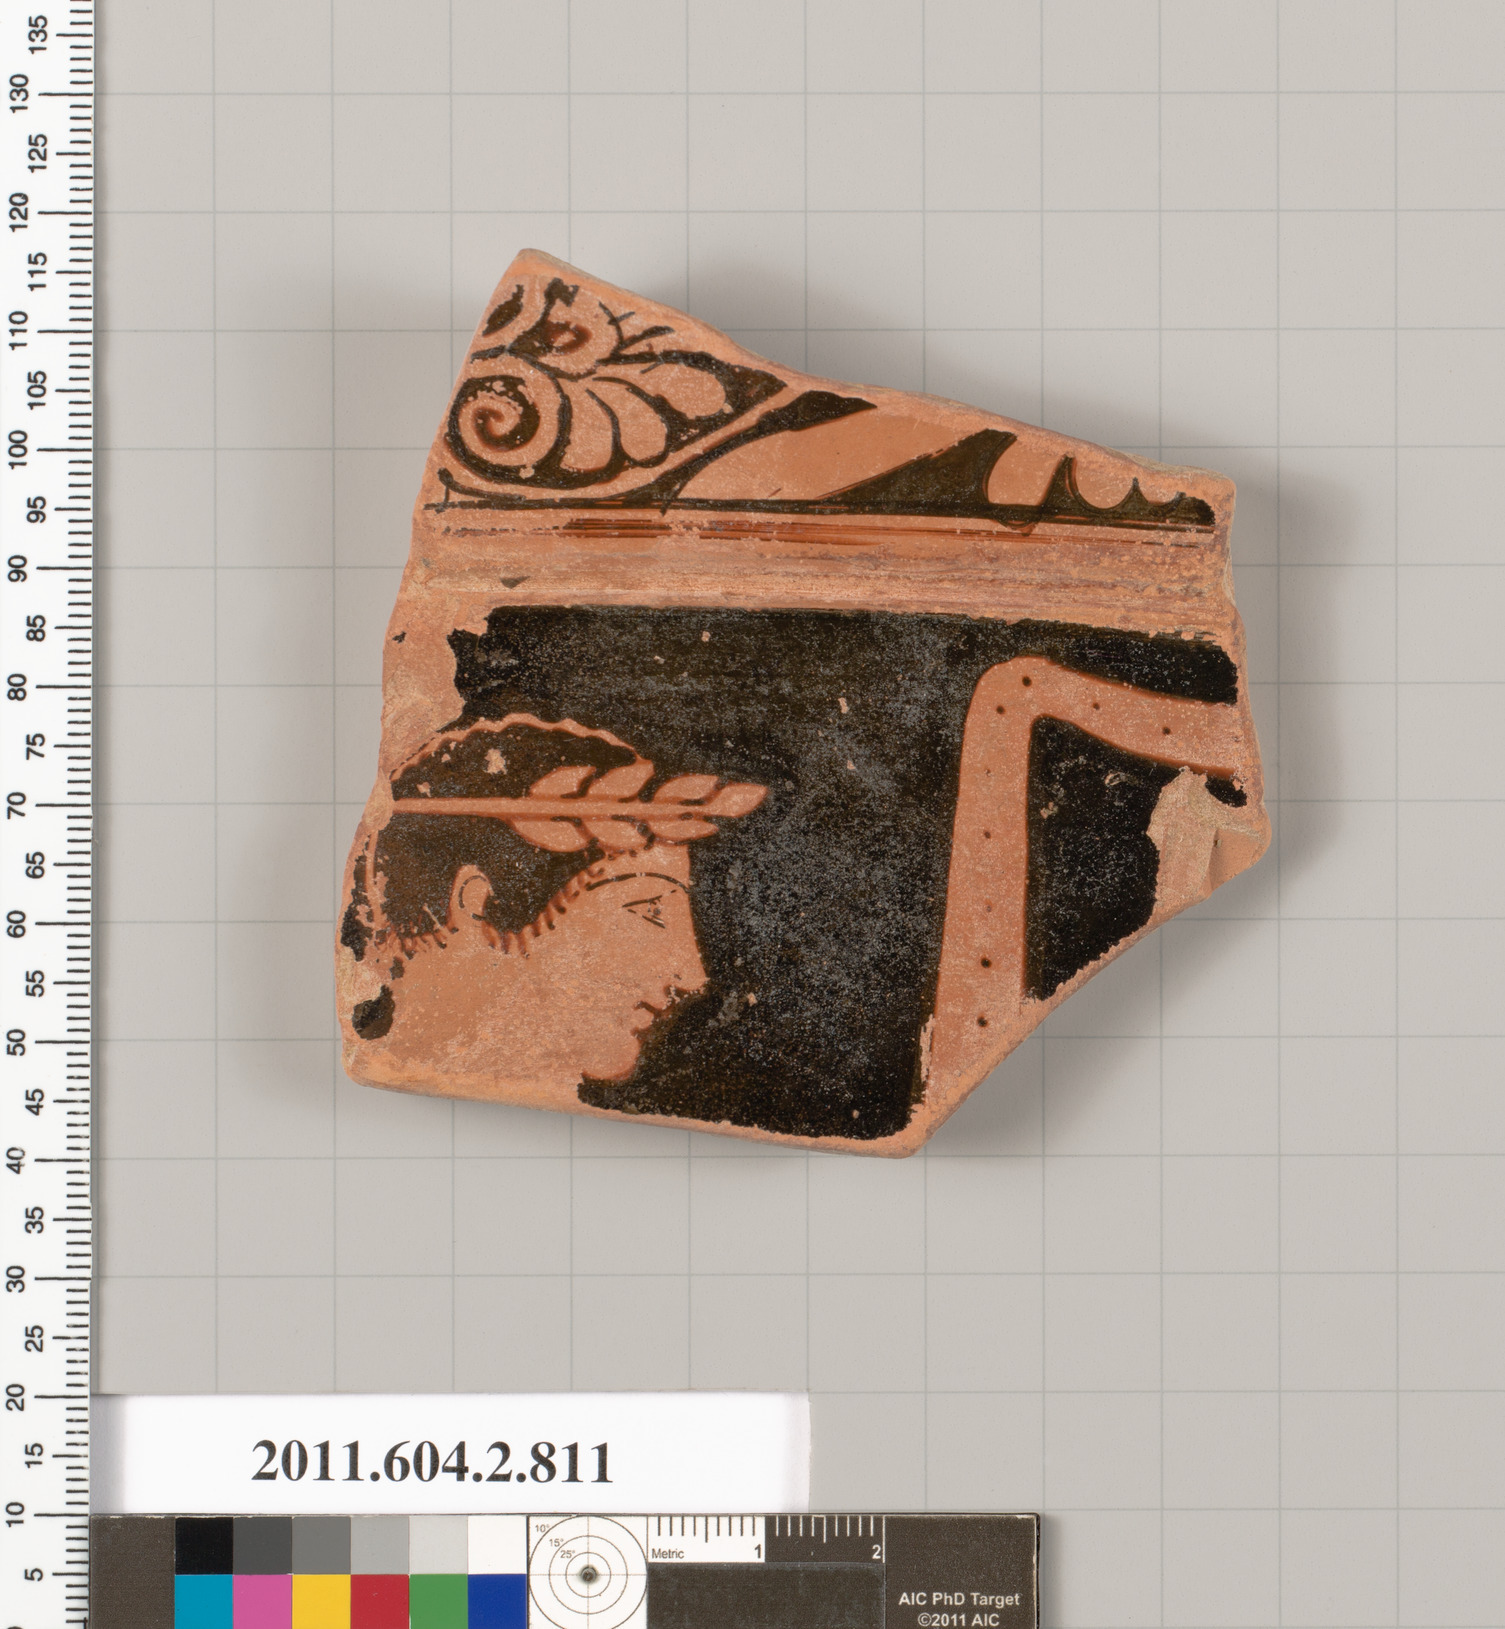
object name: bell krater fragment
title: Terracotta fragment of a bell-krater (bowl for mixing wine and water)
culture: greek, attic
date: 460-450 BCE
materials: terracotta